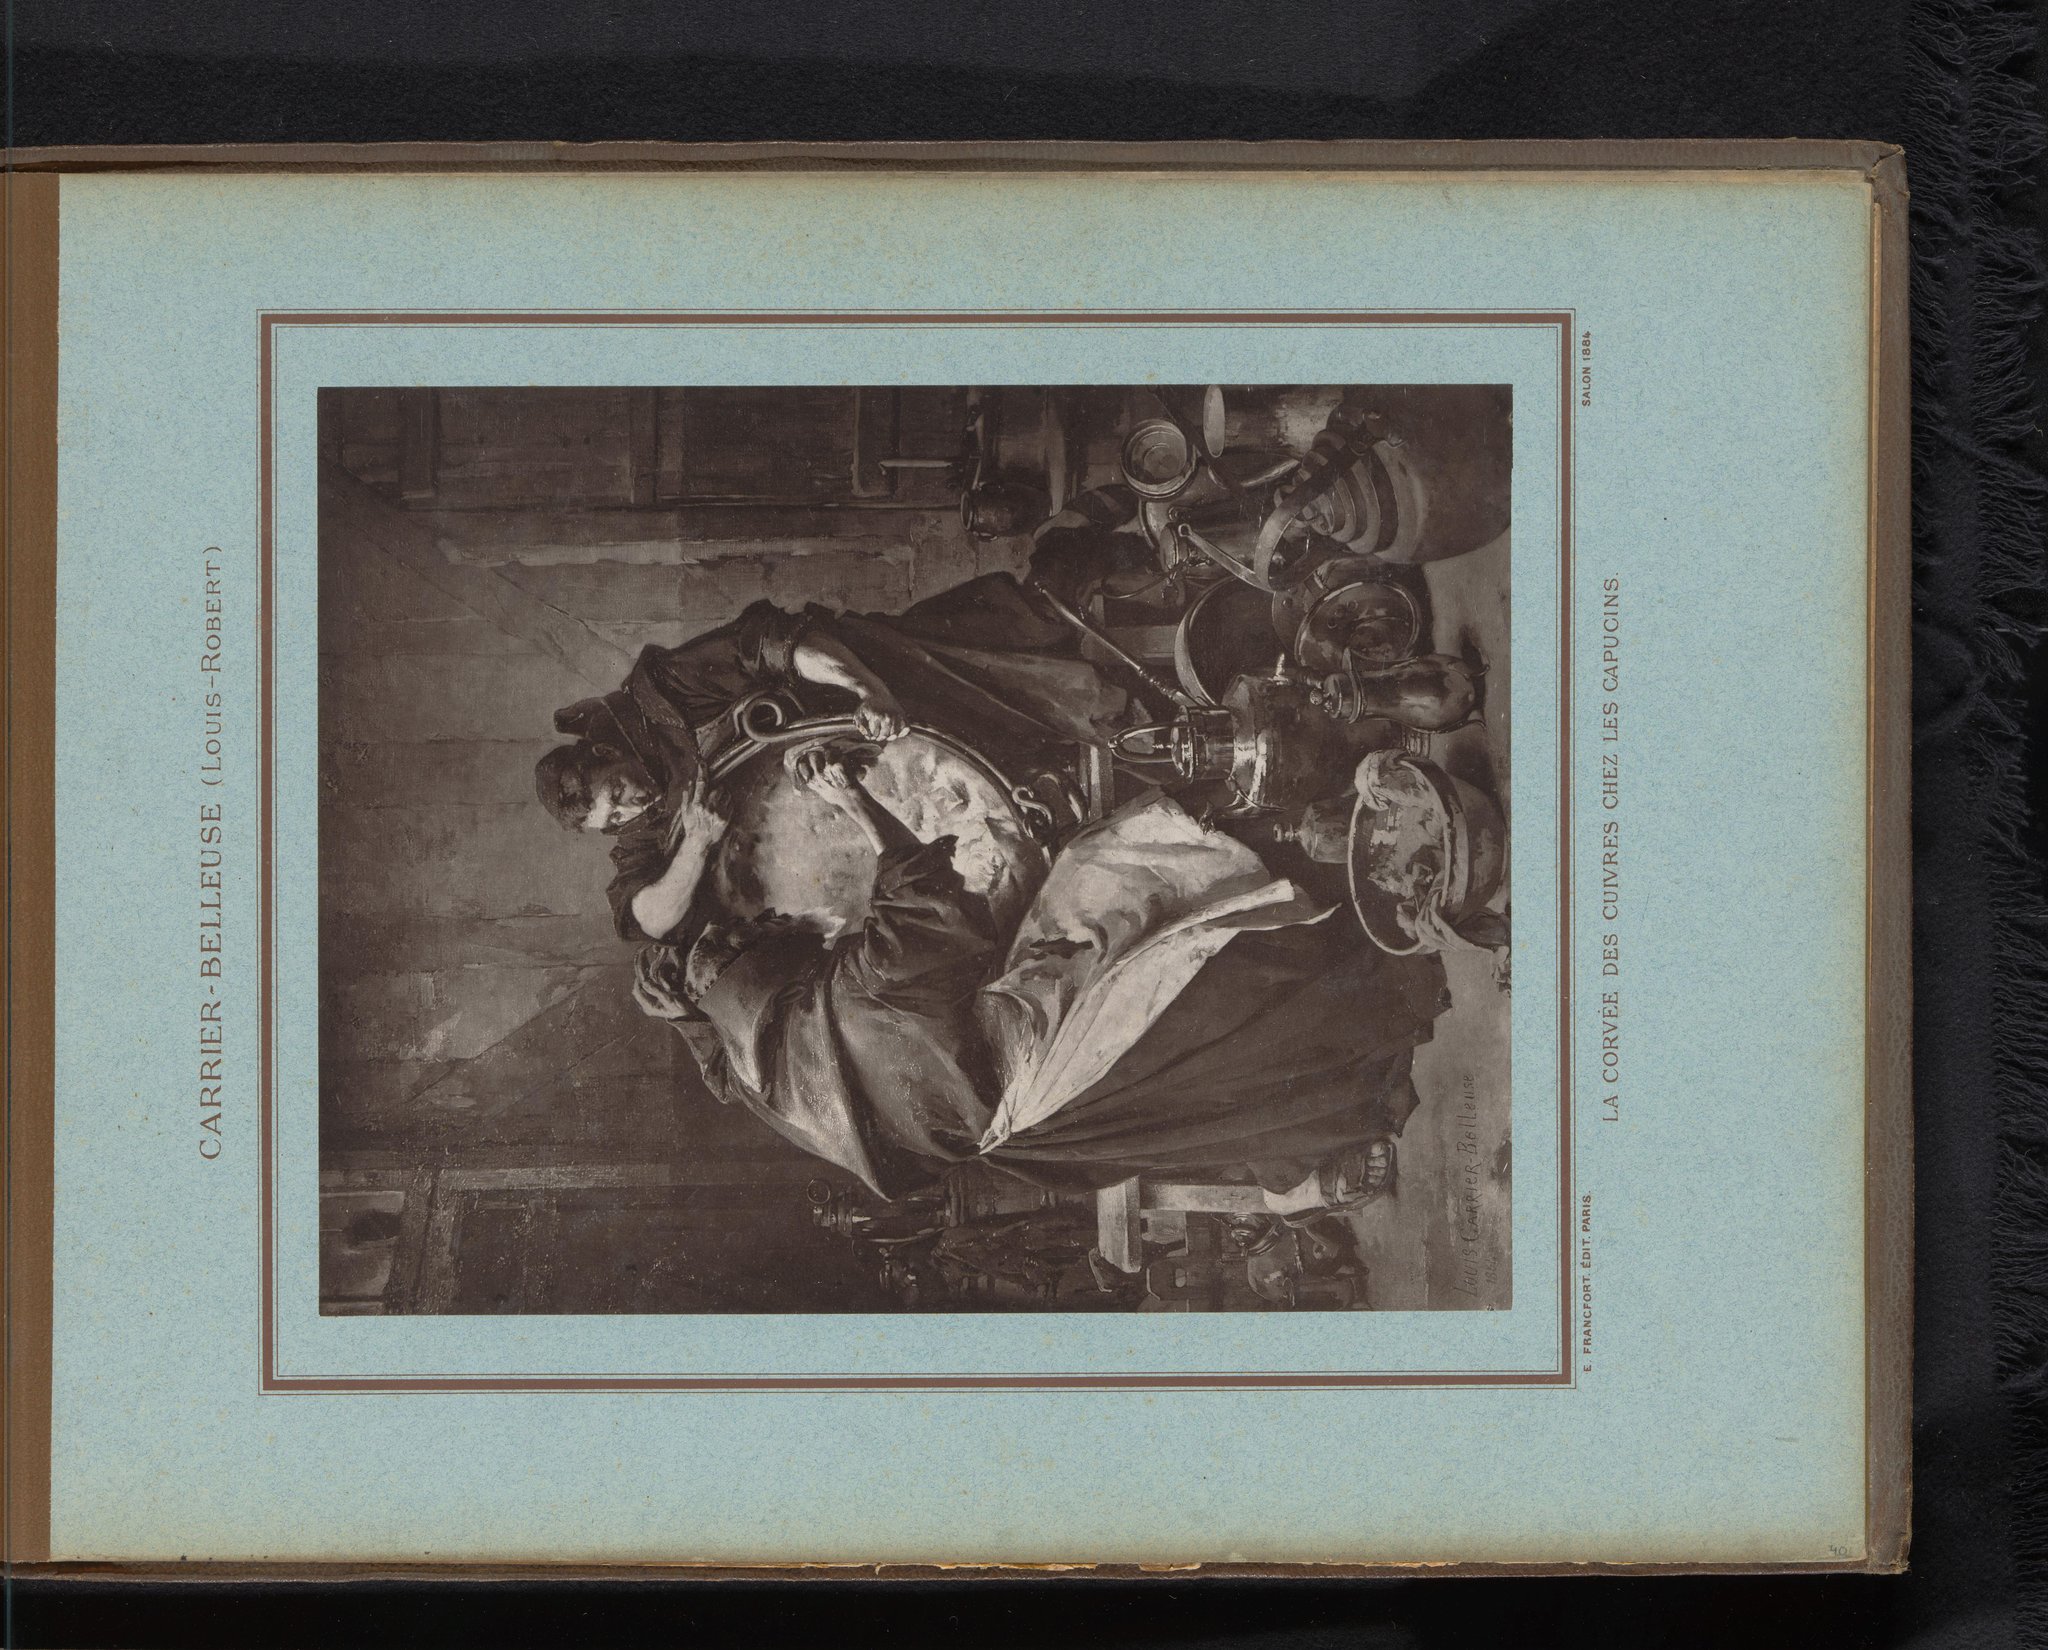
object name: photomechanical print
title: Reproductie van een schilderij van twee kapucijn monniken die een pot schoonmaken, door Louis-Robert Carrier-Belleuse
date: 1879-1884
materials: paper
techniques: woodburytype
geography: paris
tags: monk(s), friar(s), washing up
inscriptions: inscription: ‘SALON 1884.’, name: ‘CARRIER-BELLEUSE (Louis-Robert)’